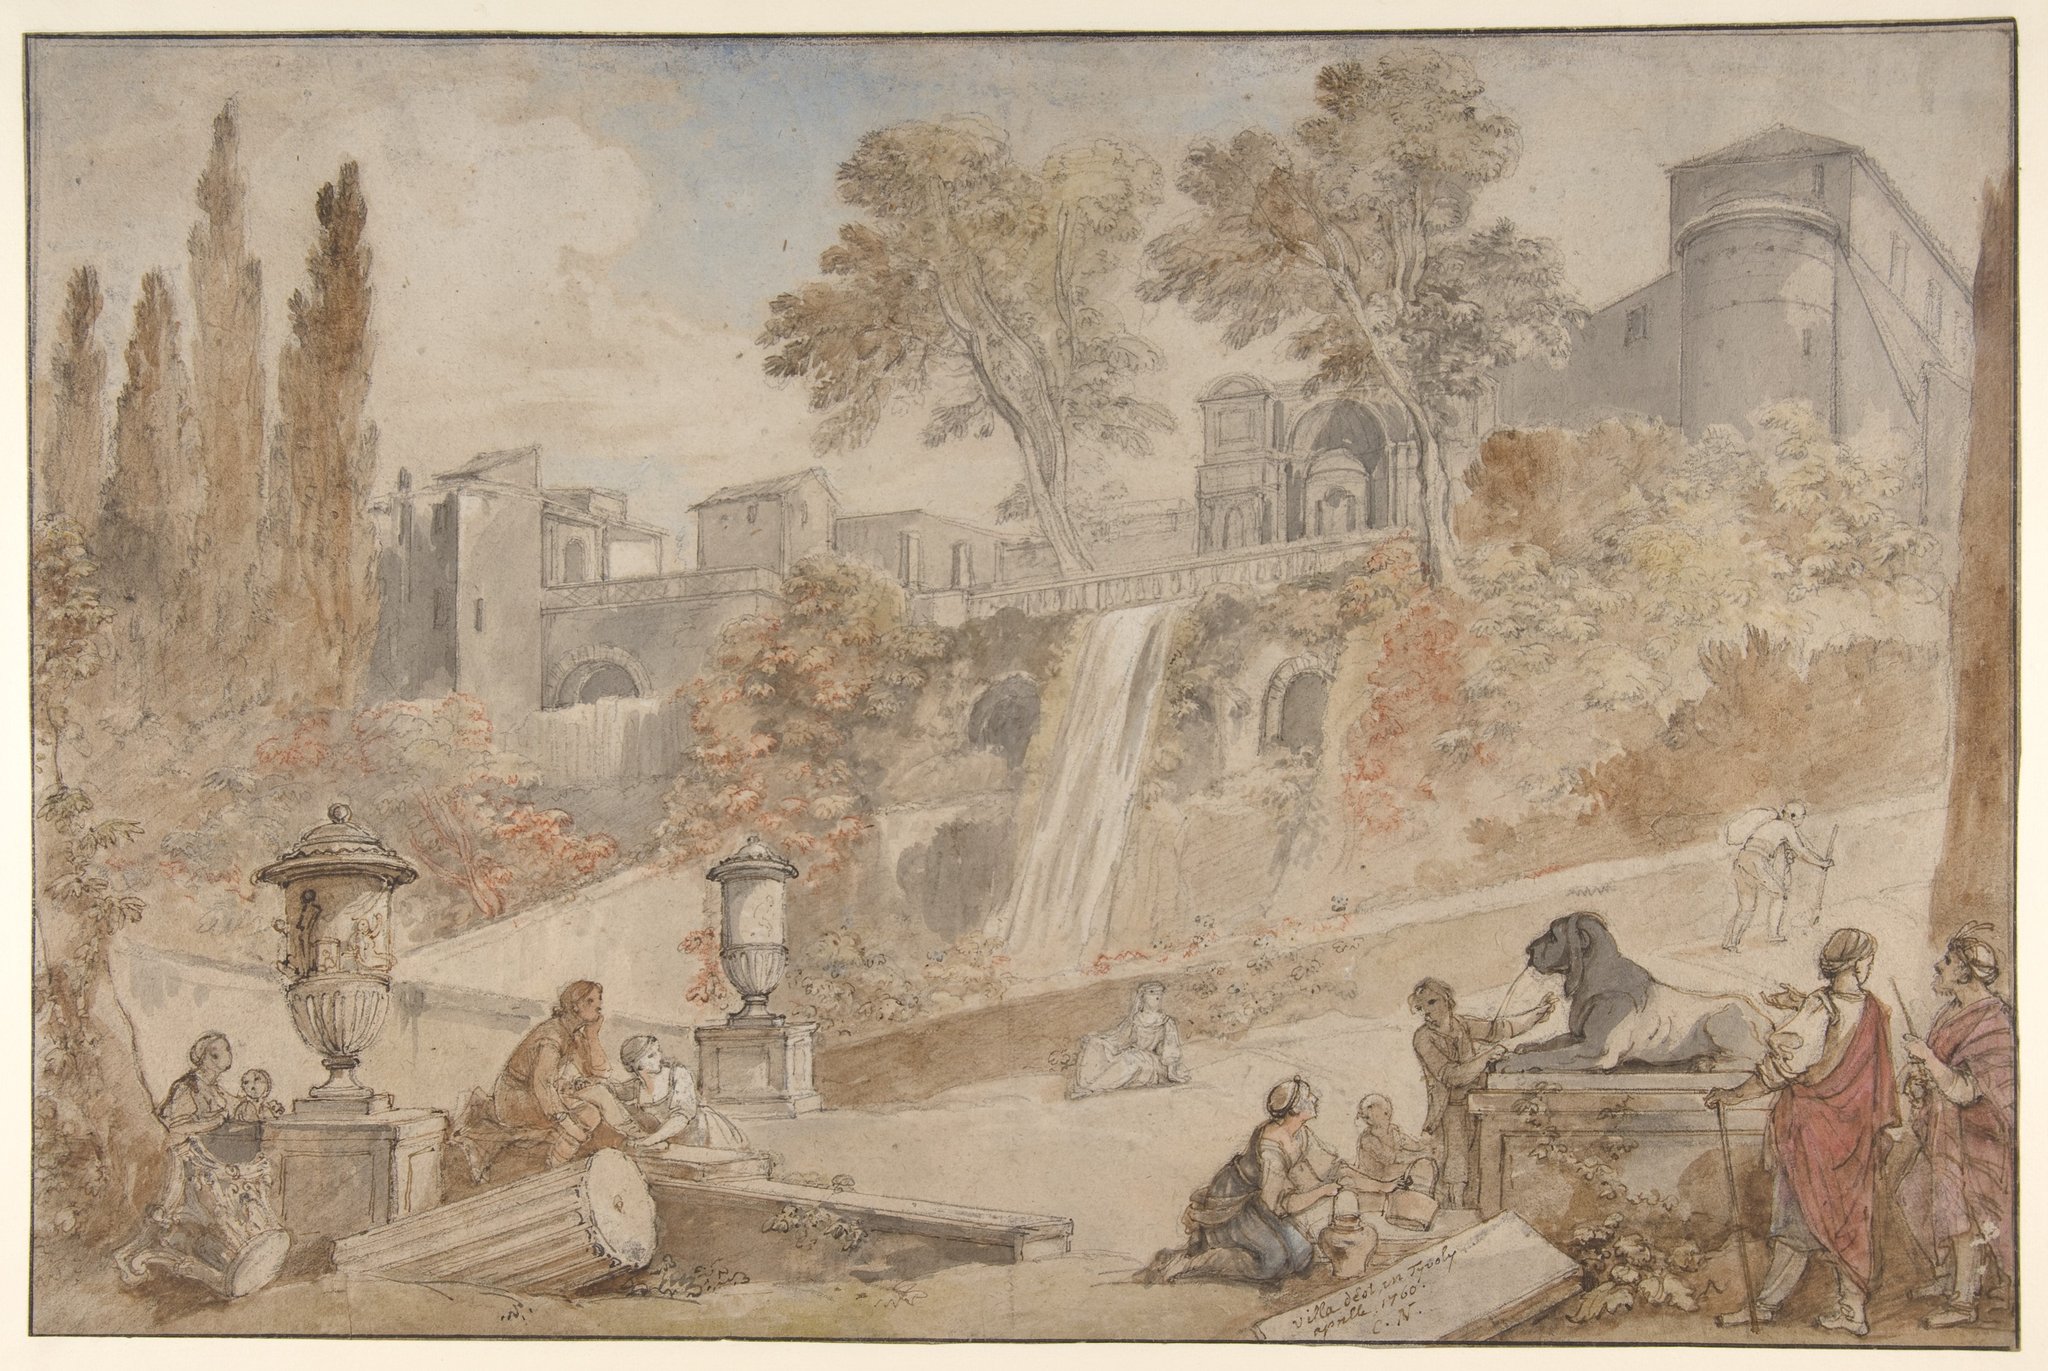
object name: drawing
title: Gardens of the Villa d'Este at Tivoli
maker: charles joseph natoire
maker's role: artist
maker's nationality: french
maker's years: 1700-1777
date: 1760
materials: chalk, ink, watercolor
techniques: brush, heightening, pen, wash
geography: france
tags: fountains,gardens